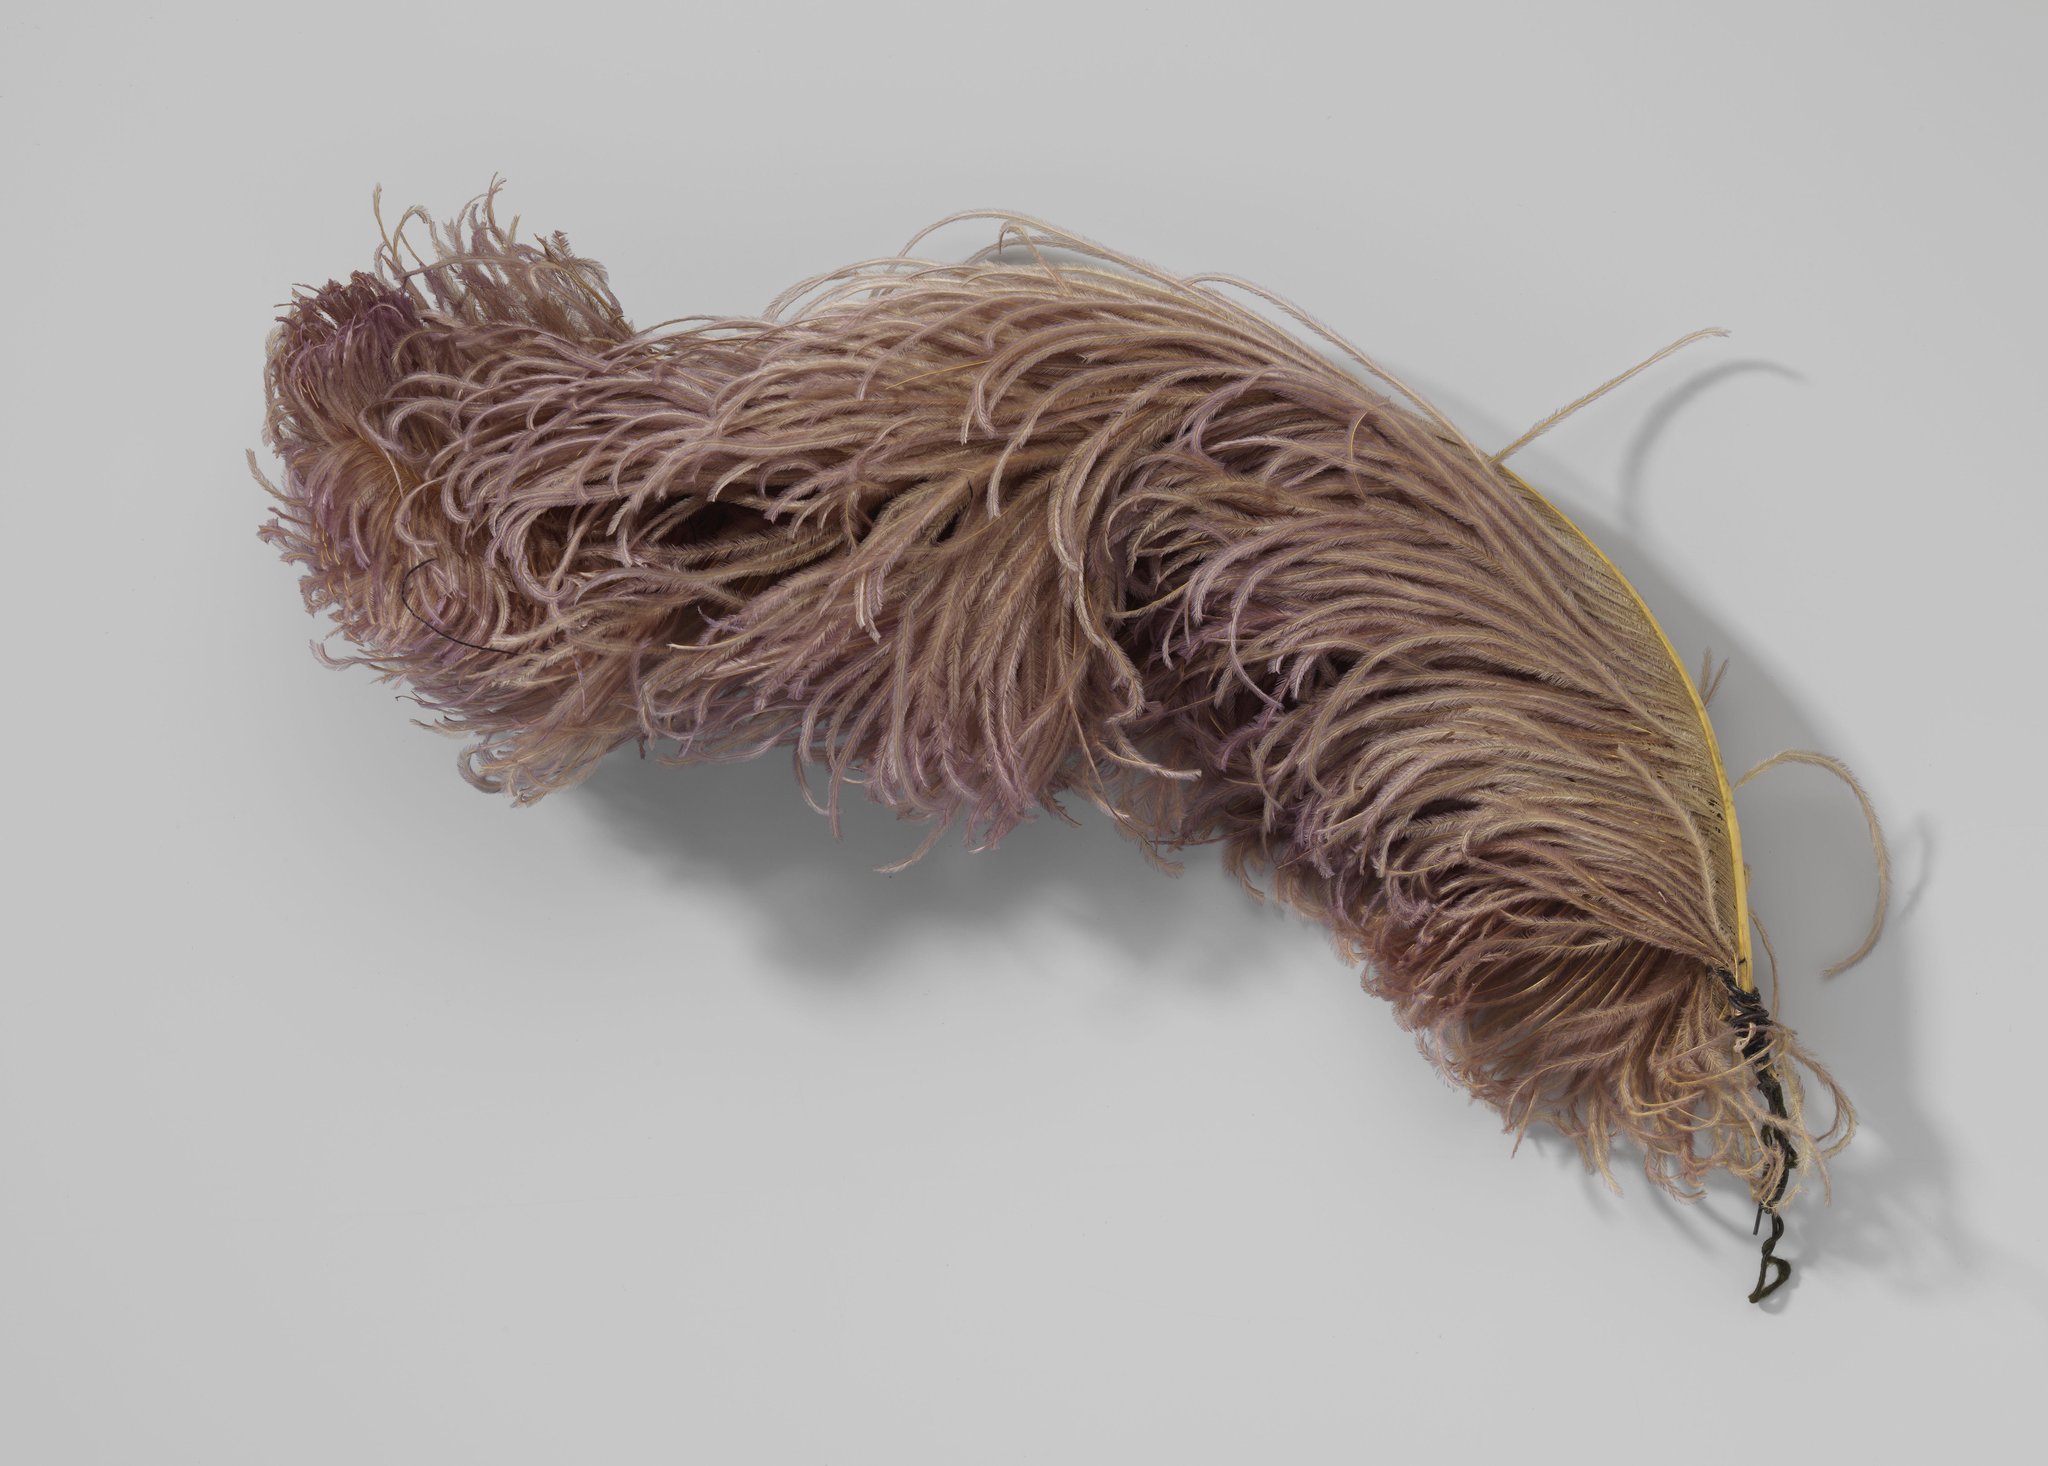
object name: womenswear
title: Toef struisveren in gemeleerd geel en grijs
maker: Anonymous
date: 1880-1925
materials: metal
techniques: painting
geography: western europe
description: Toef struisveren in gemeleerd geel en grijs.